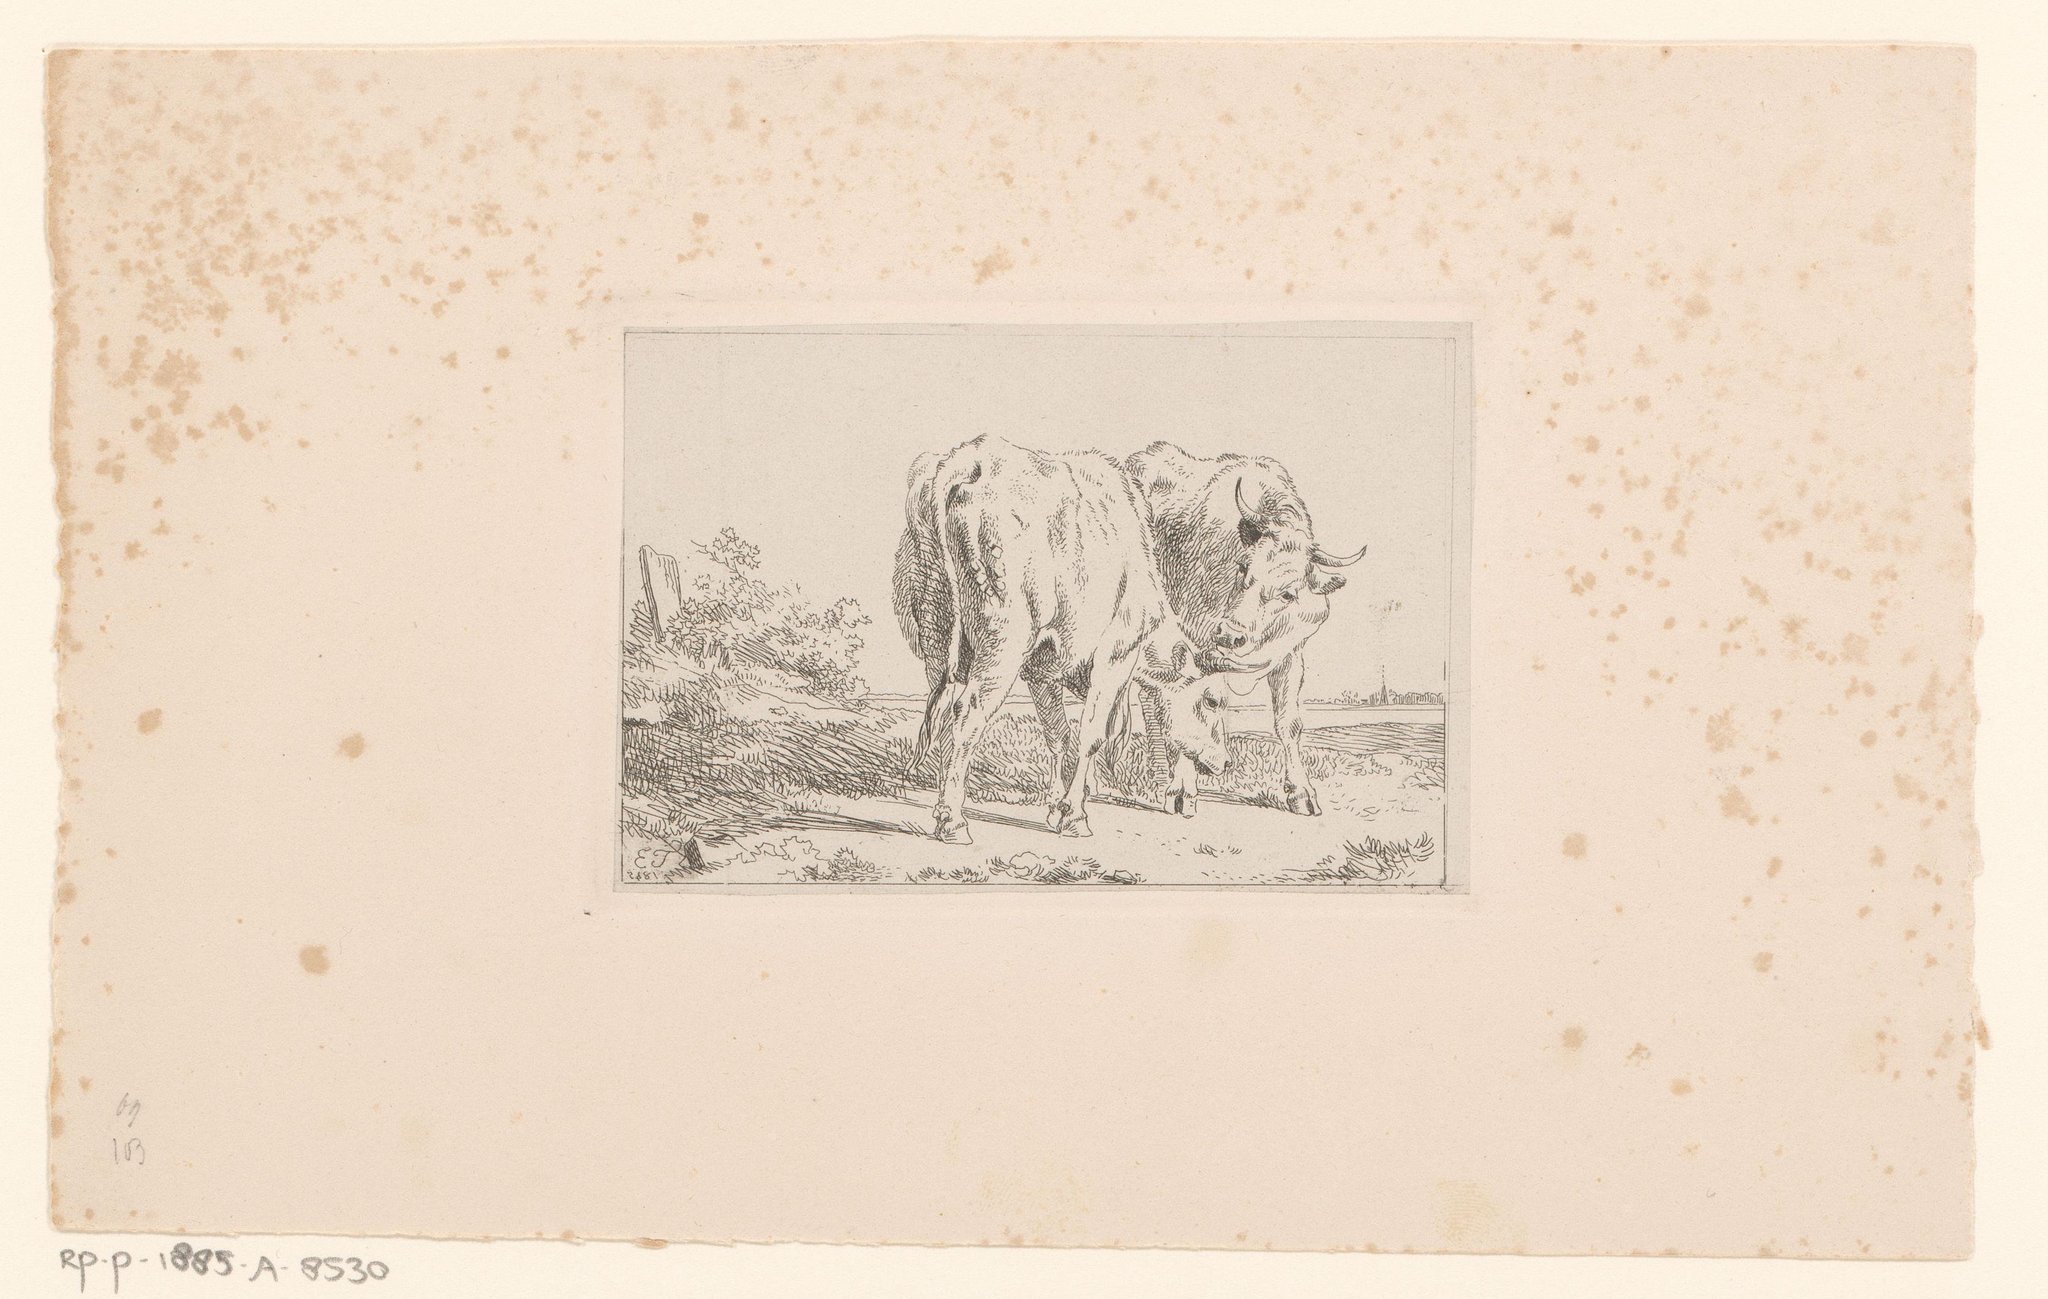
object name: print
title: Landschap met twee runderen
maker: edmond tschaggeny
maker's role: print maker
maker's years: 1818-1873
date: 1845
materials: paper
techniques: etching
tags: bovine cattle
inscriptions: collector's mark: Lugt 2228